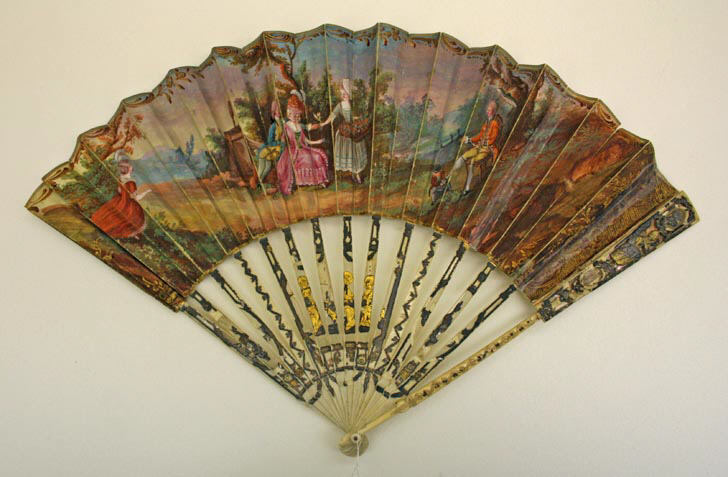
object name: fan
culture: french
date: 1767-1800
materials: ivory, silk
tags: men,women